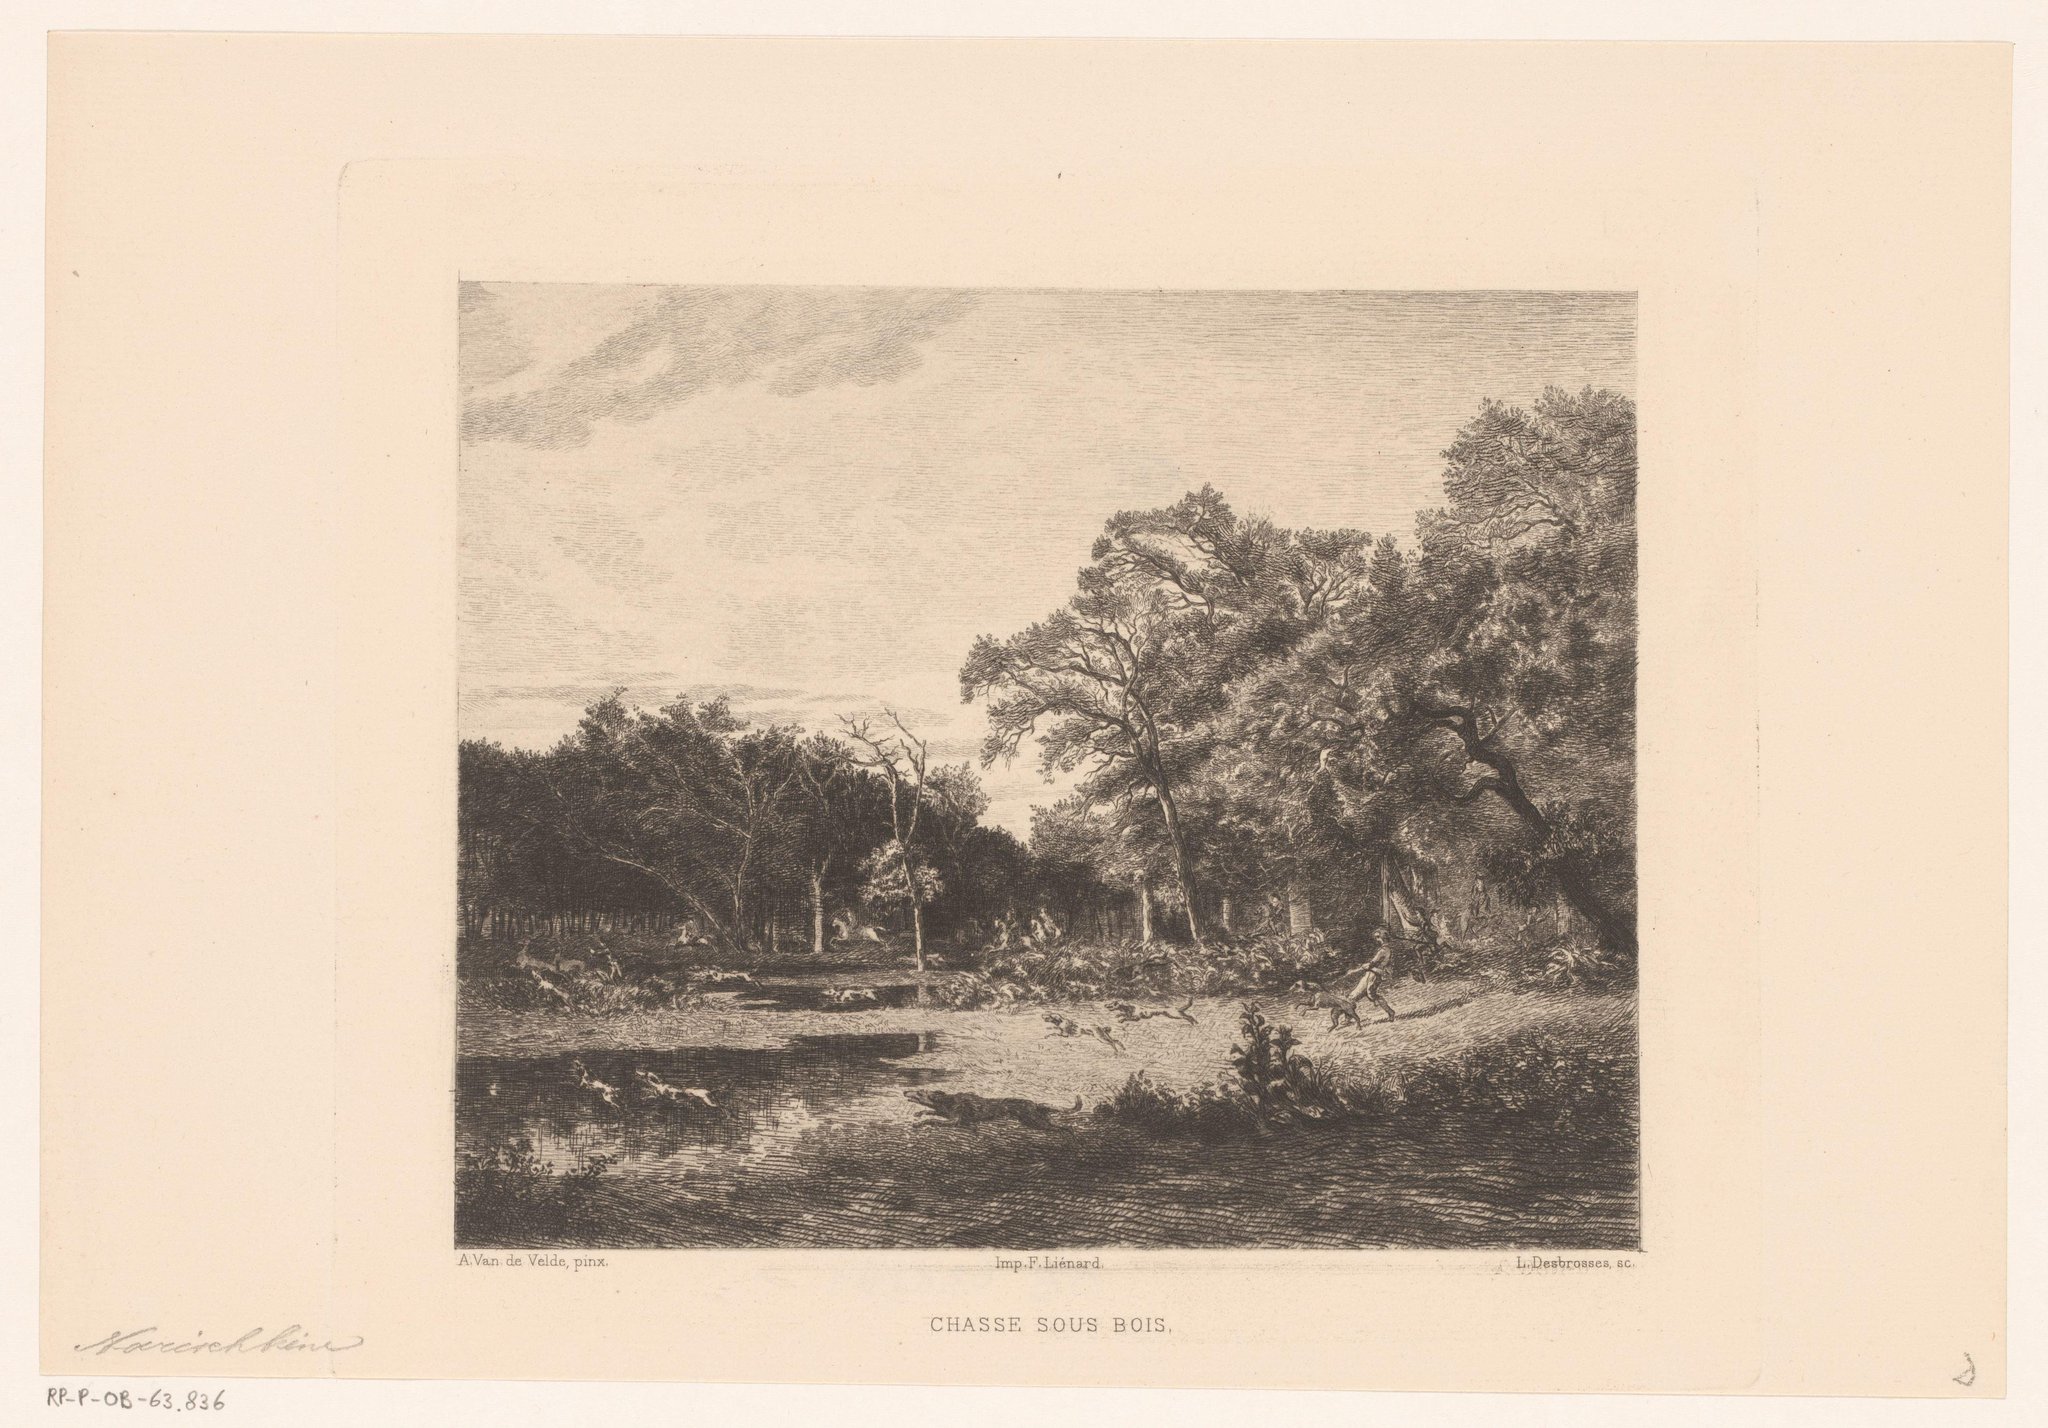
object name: print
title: Chasse sous Bois.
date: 1831-1907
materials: paper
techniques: etching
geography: paris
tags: hunting, chase, forest, wood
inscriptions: collector's mark: Lugt 2228